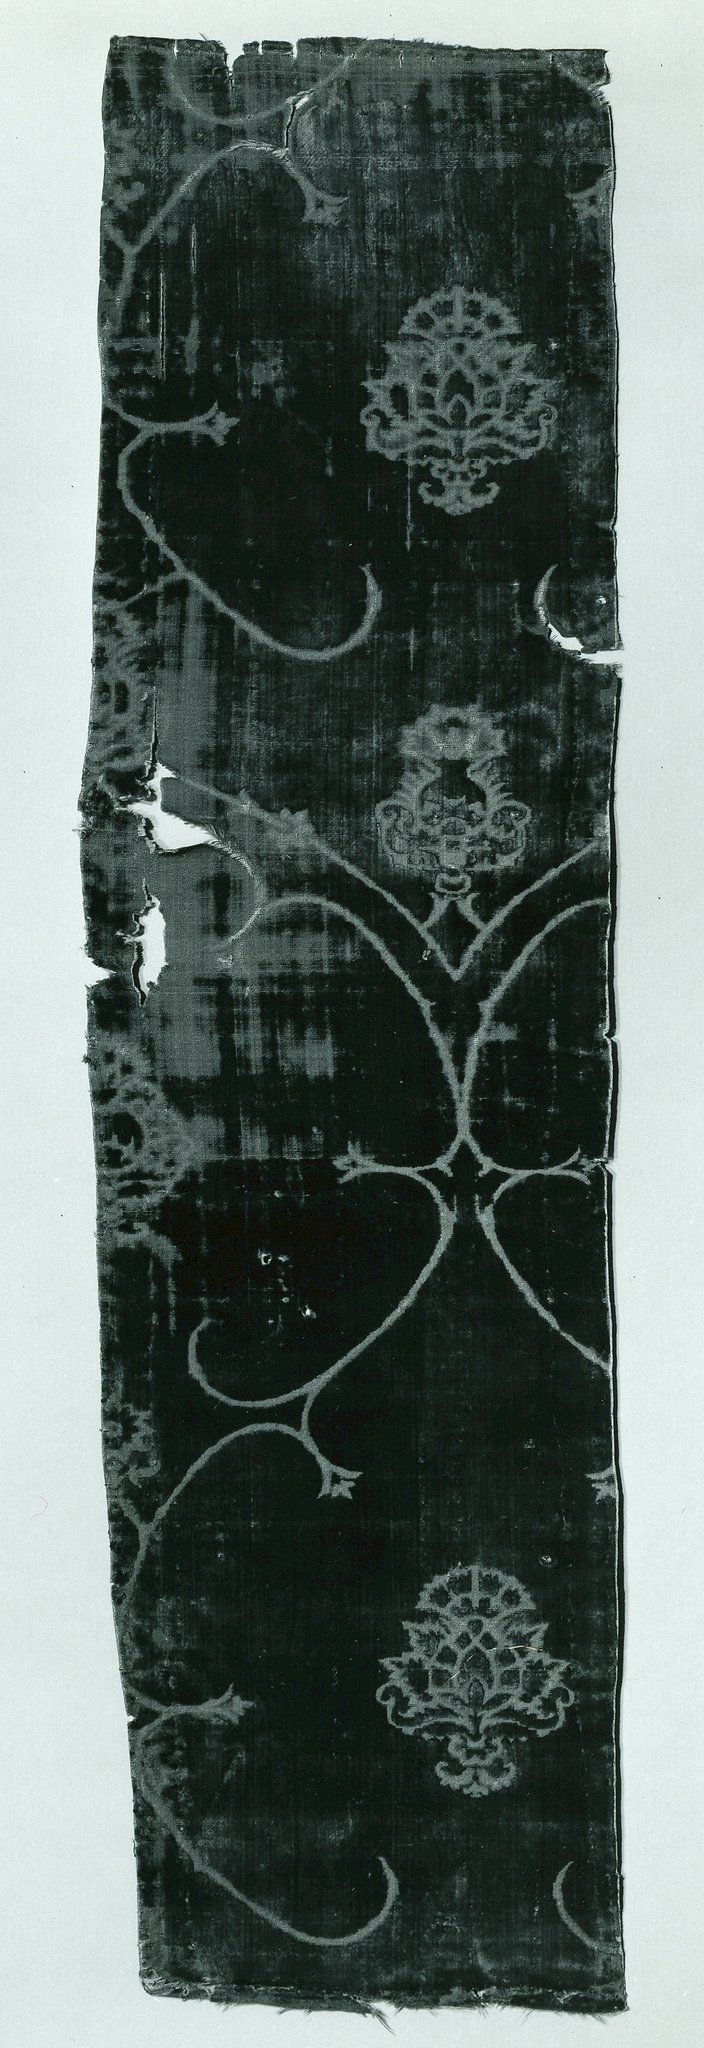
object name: textile fragment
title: Fragment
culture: spanish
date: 1434-1466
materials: silk